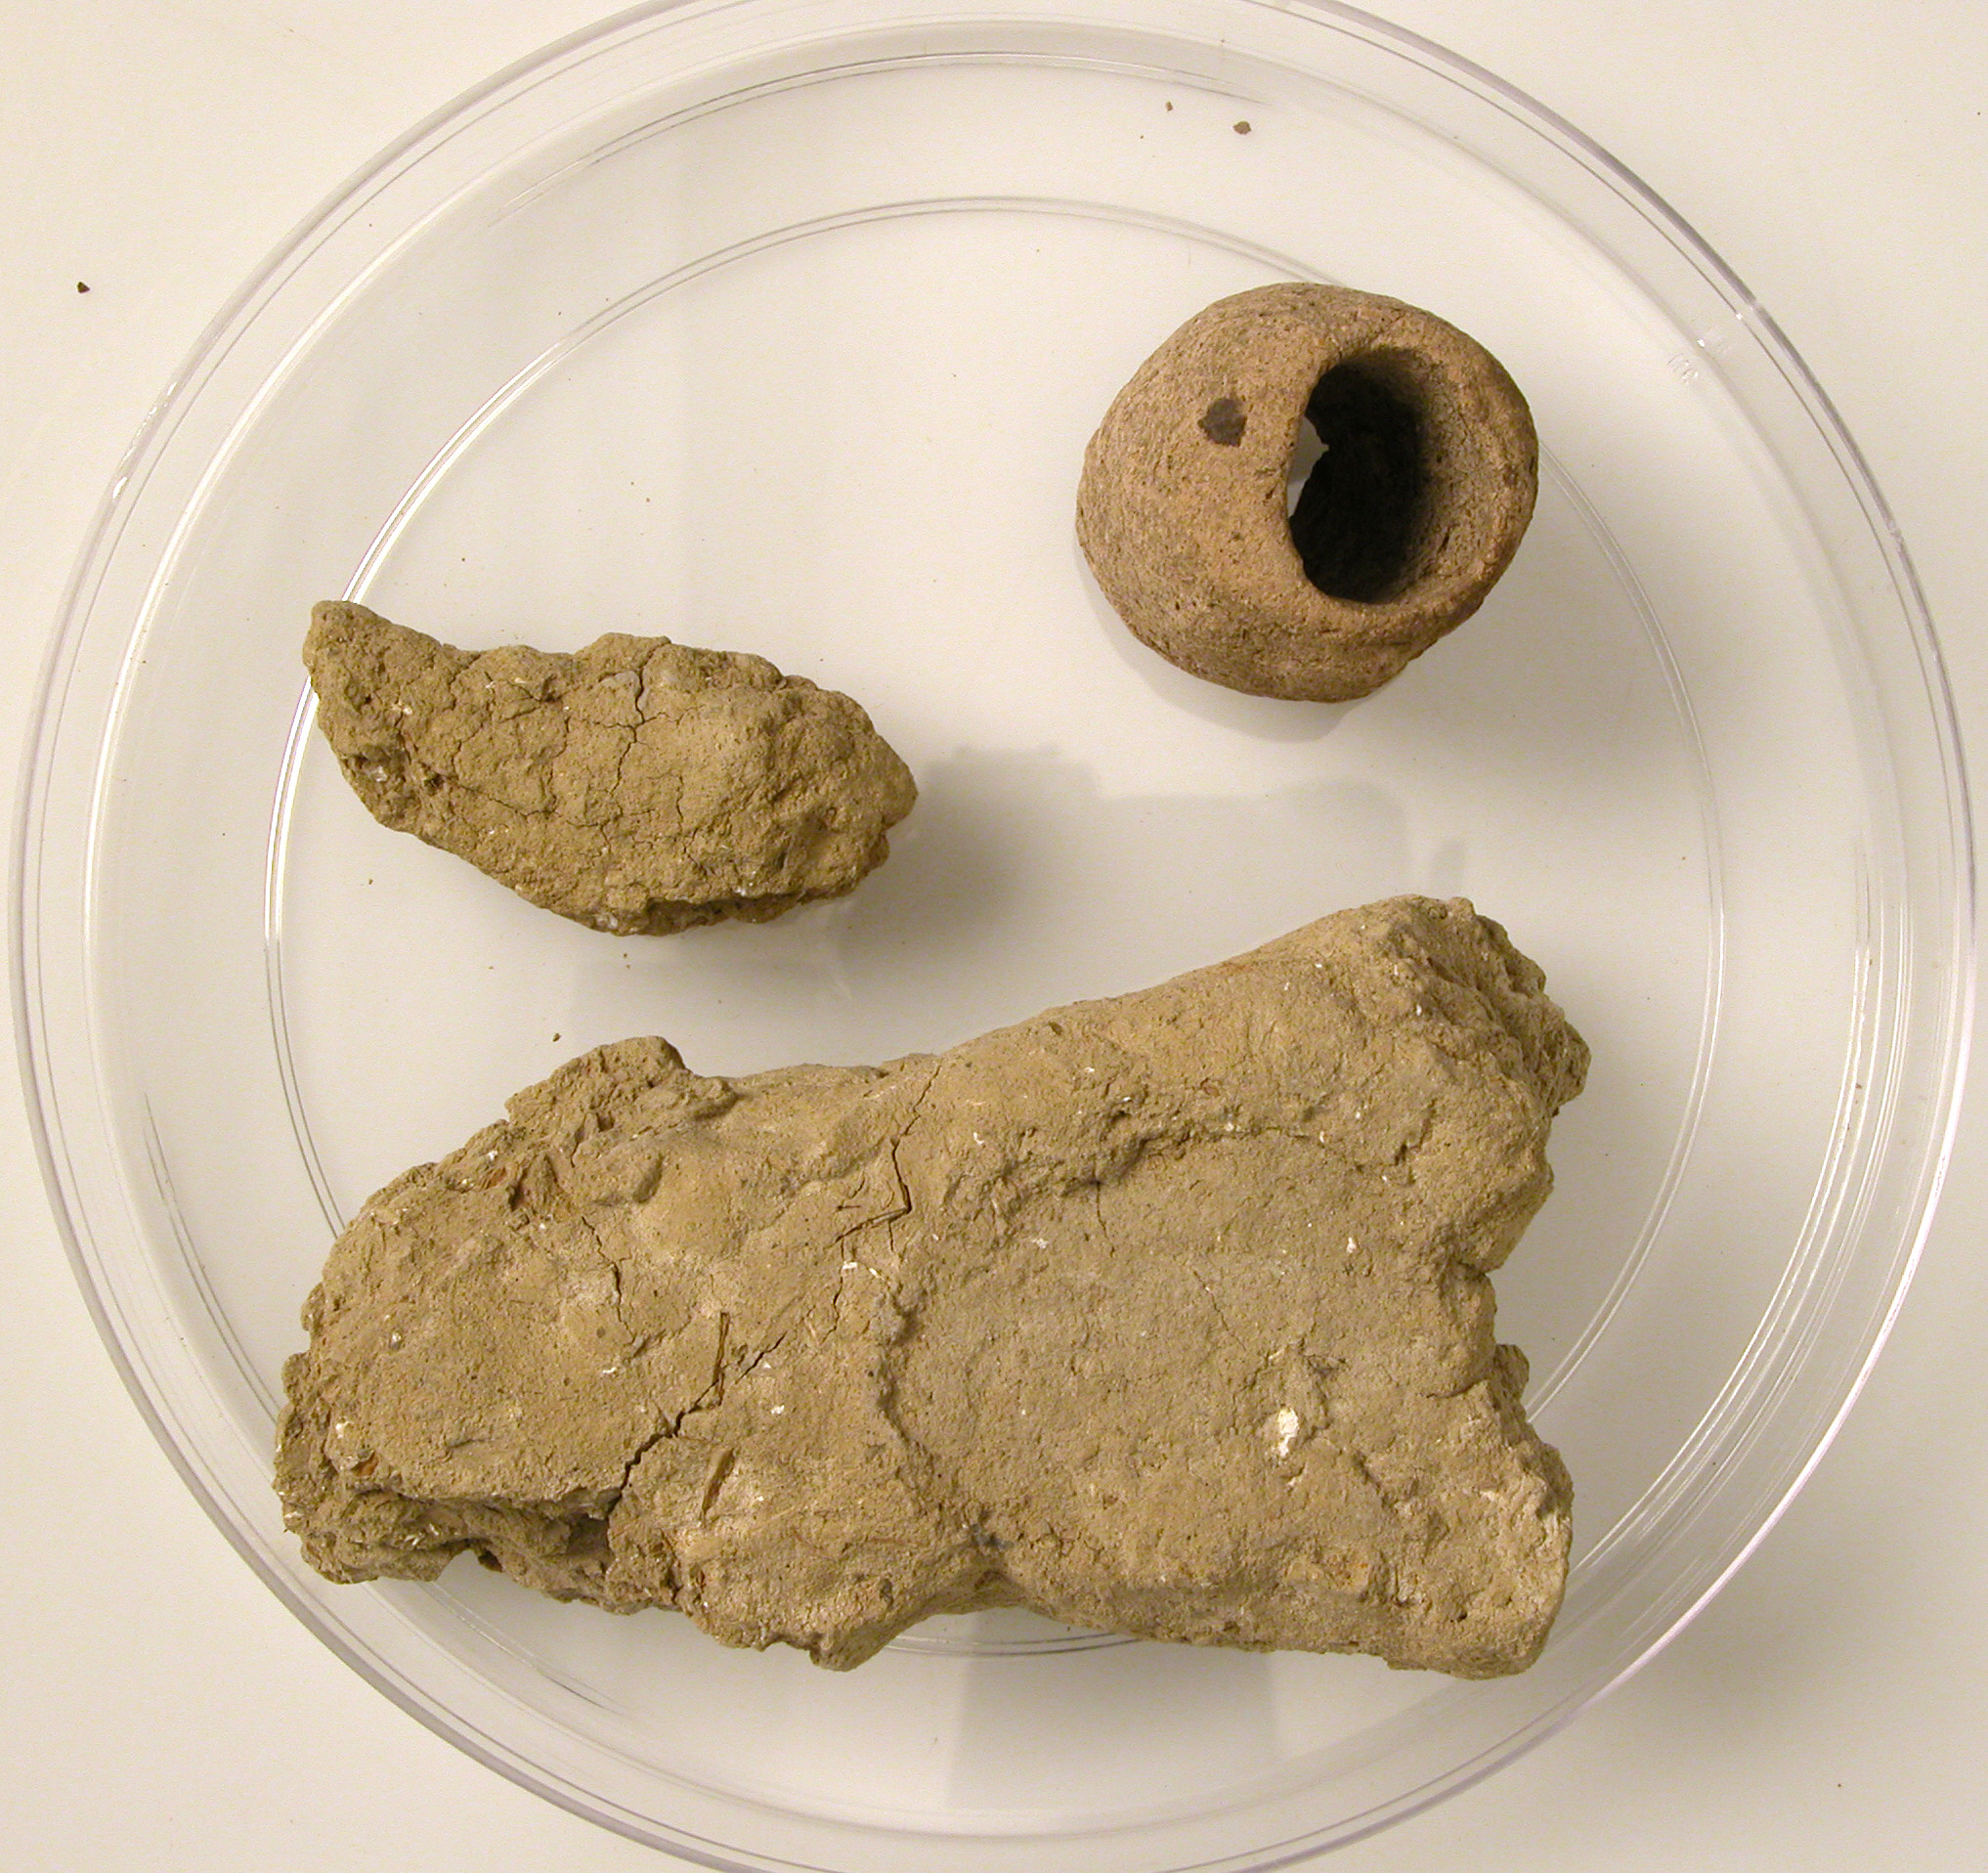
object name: fragment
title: Mud Fragments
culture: coptic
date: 301-700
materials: mud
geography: egypt